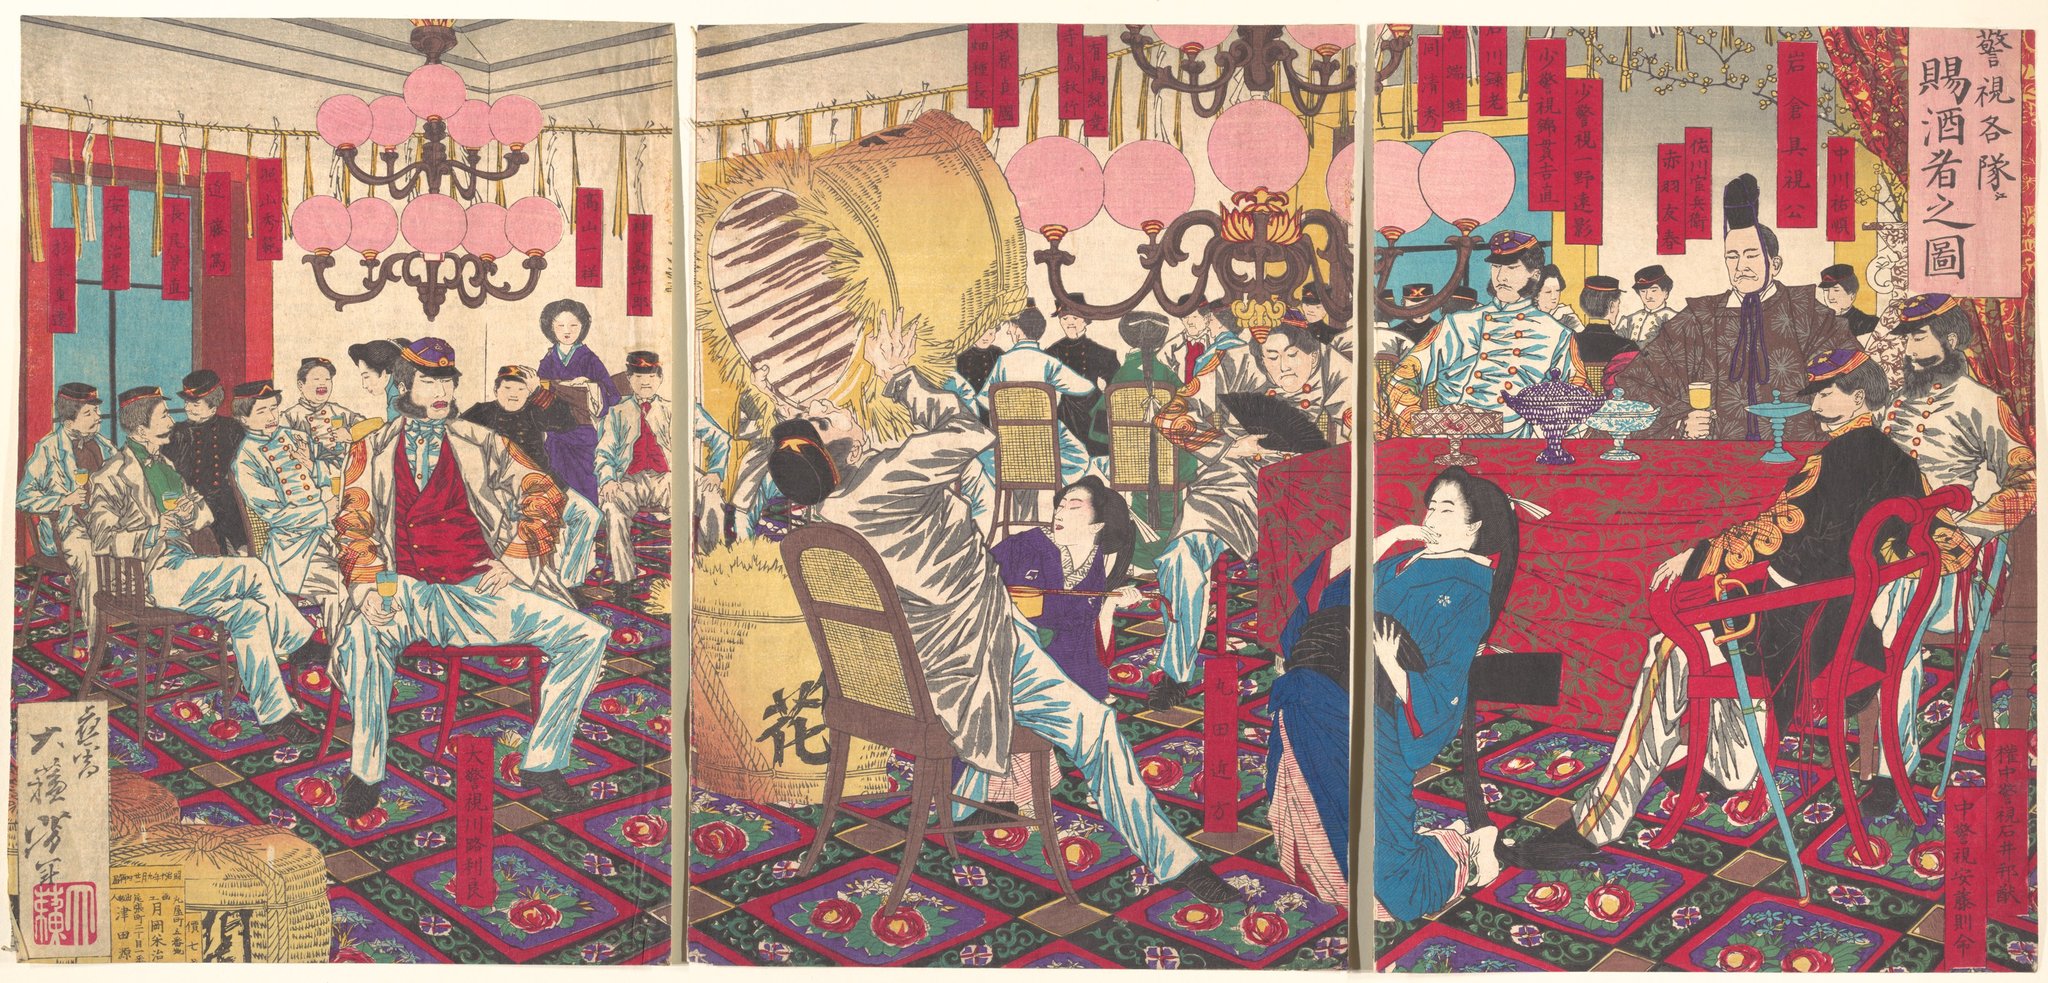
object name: print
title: Police Superintendant's Party: A Gift of Food and Drink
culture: japanese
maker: tsukioka yoshitoshi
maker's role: artist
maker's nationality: japanese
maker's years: 1839-1892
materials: ink, paper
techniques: woodblock print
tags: men,women,party,drinking,police